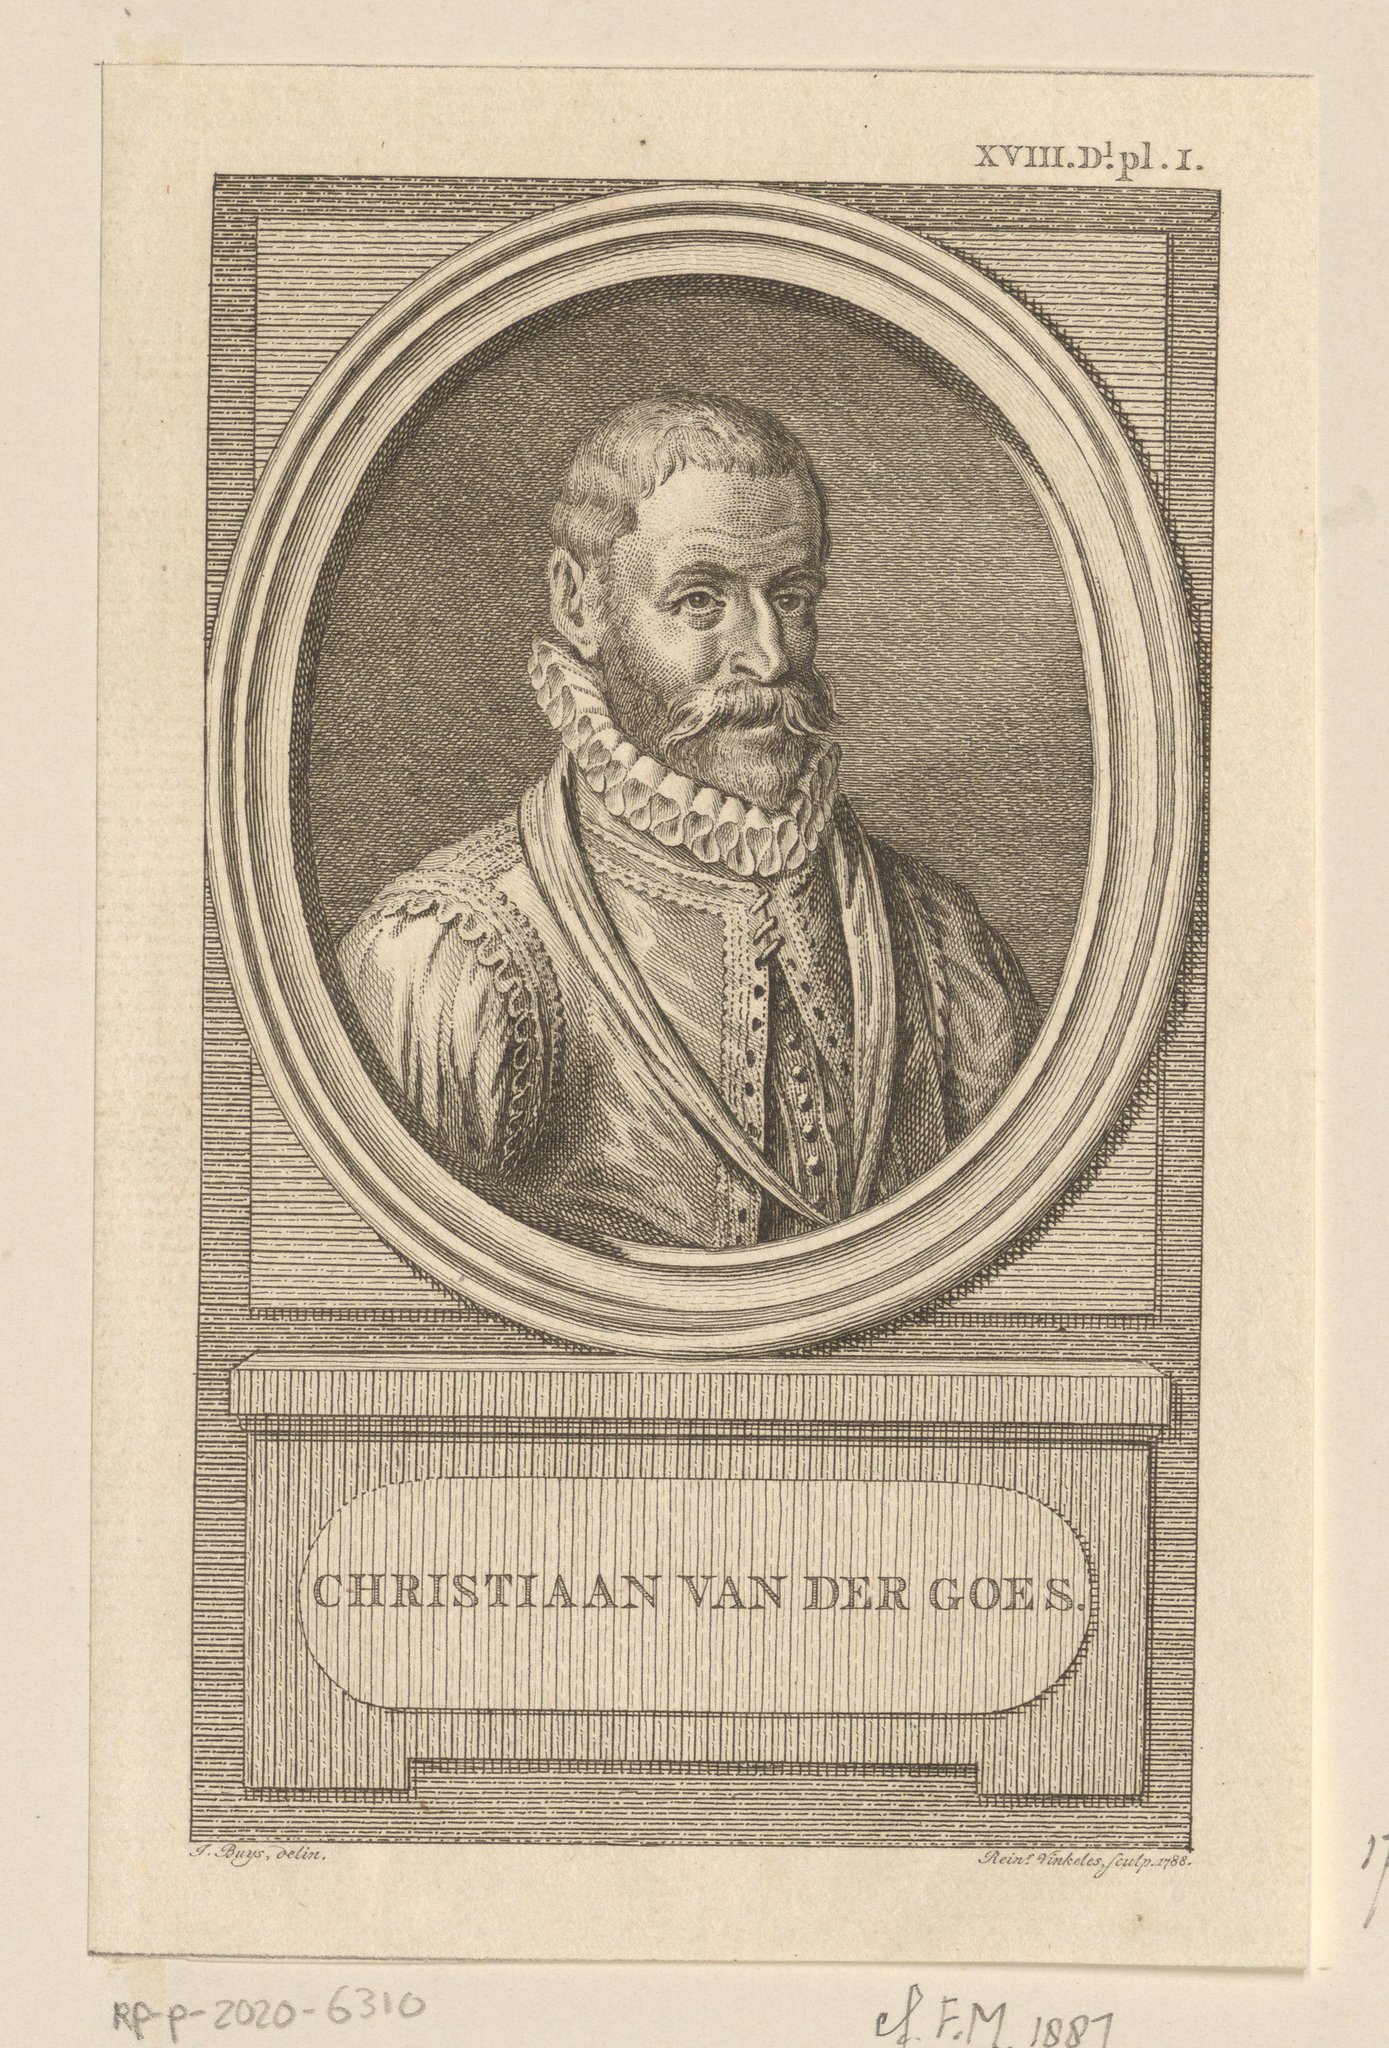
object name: book illustration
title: Portret van Christiaan van der Goes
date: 1788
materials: paper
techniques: engraving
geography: amsterdam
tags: delft, historical persons, politician, e.g. party leader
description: Prent uit: Kok, Jacobus. Vaderlandsch woordenboek : met kaarten, plaaten en pourtraitten. Amsterdam: Johannes Allart, 1788, dl. 18.